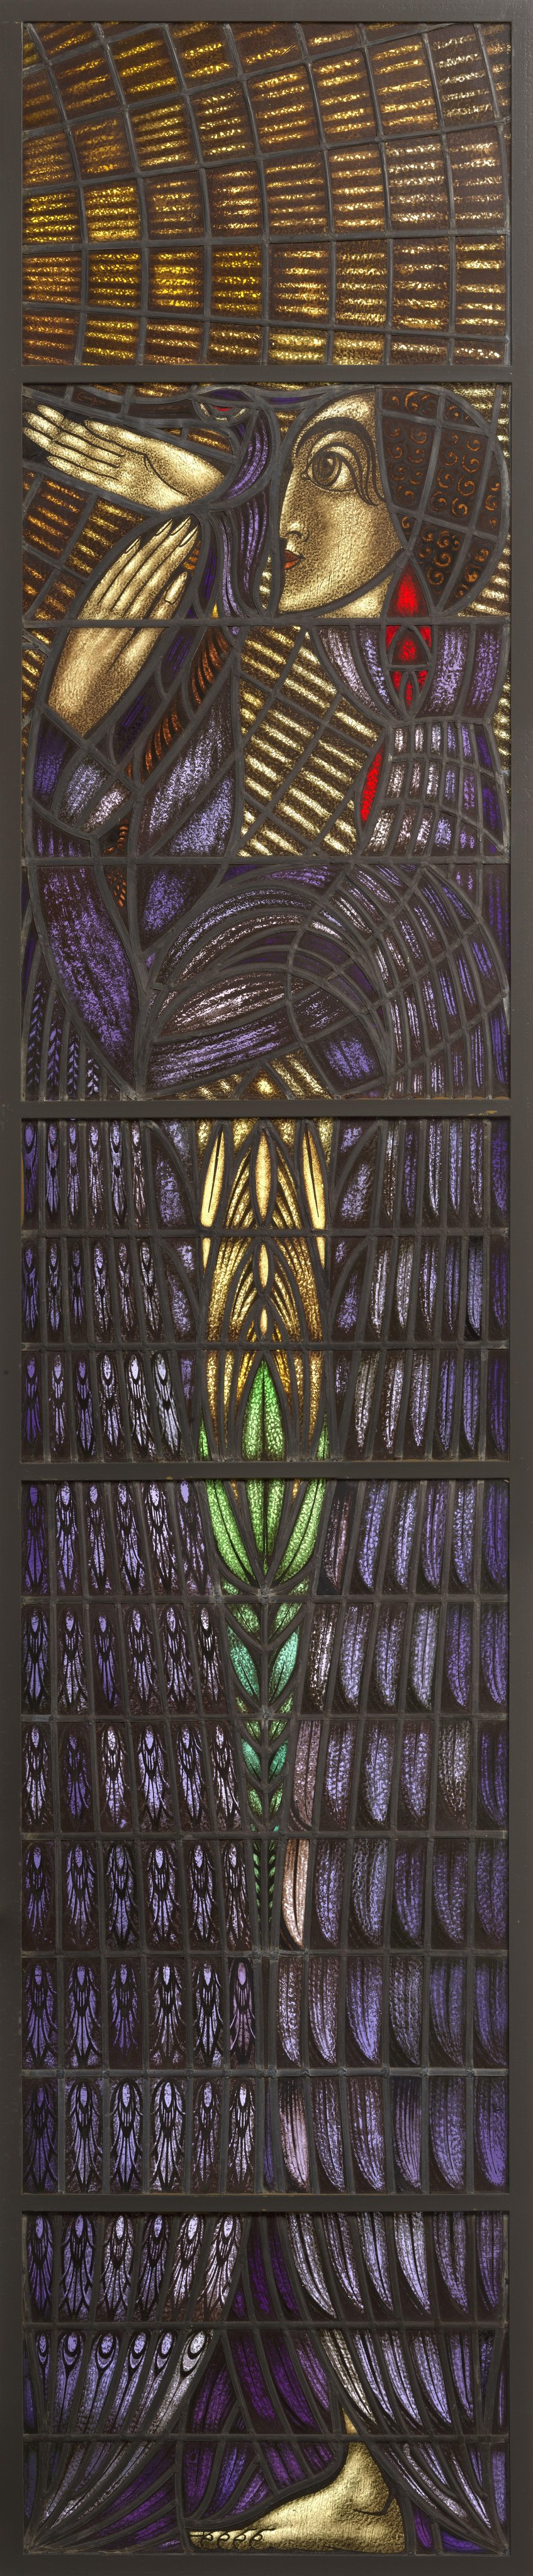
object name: light window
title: Ruit, gebrandschilderd, ontwerp Lebeau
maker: chris lebeau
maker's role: draughtsman, print maker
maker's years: 1878-1945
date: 1926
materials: glass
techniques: enamel painting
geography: netherlands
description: Ruit van gebrandschilderd glas, in 1926 vervaardigd voor het trappenhuis van het woonhuis van mevrouw C.G. Verburgt-Kramers, Schiefbaanstraat 29 te Den Haag.